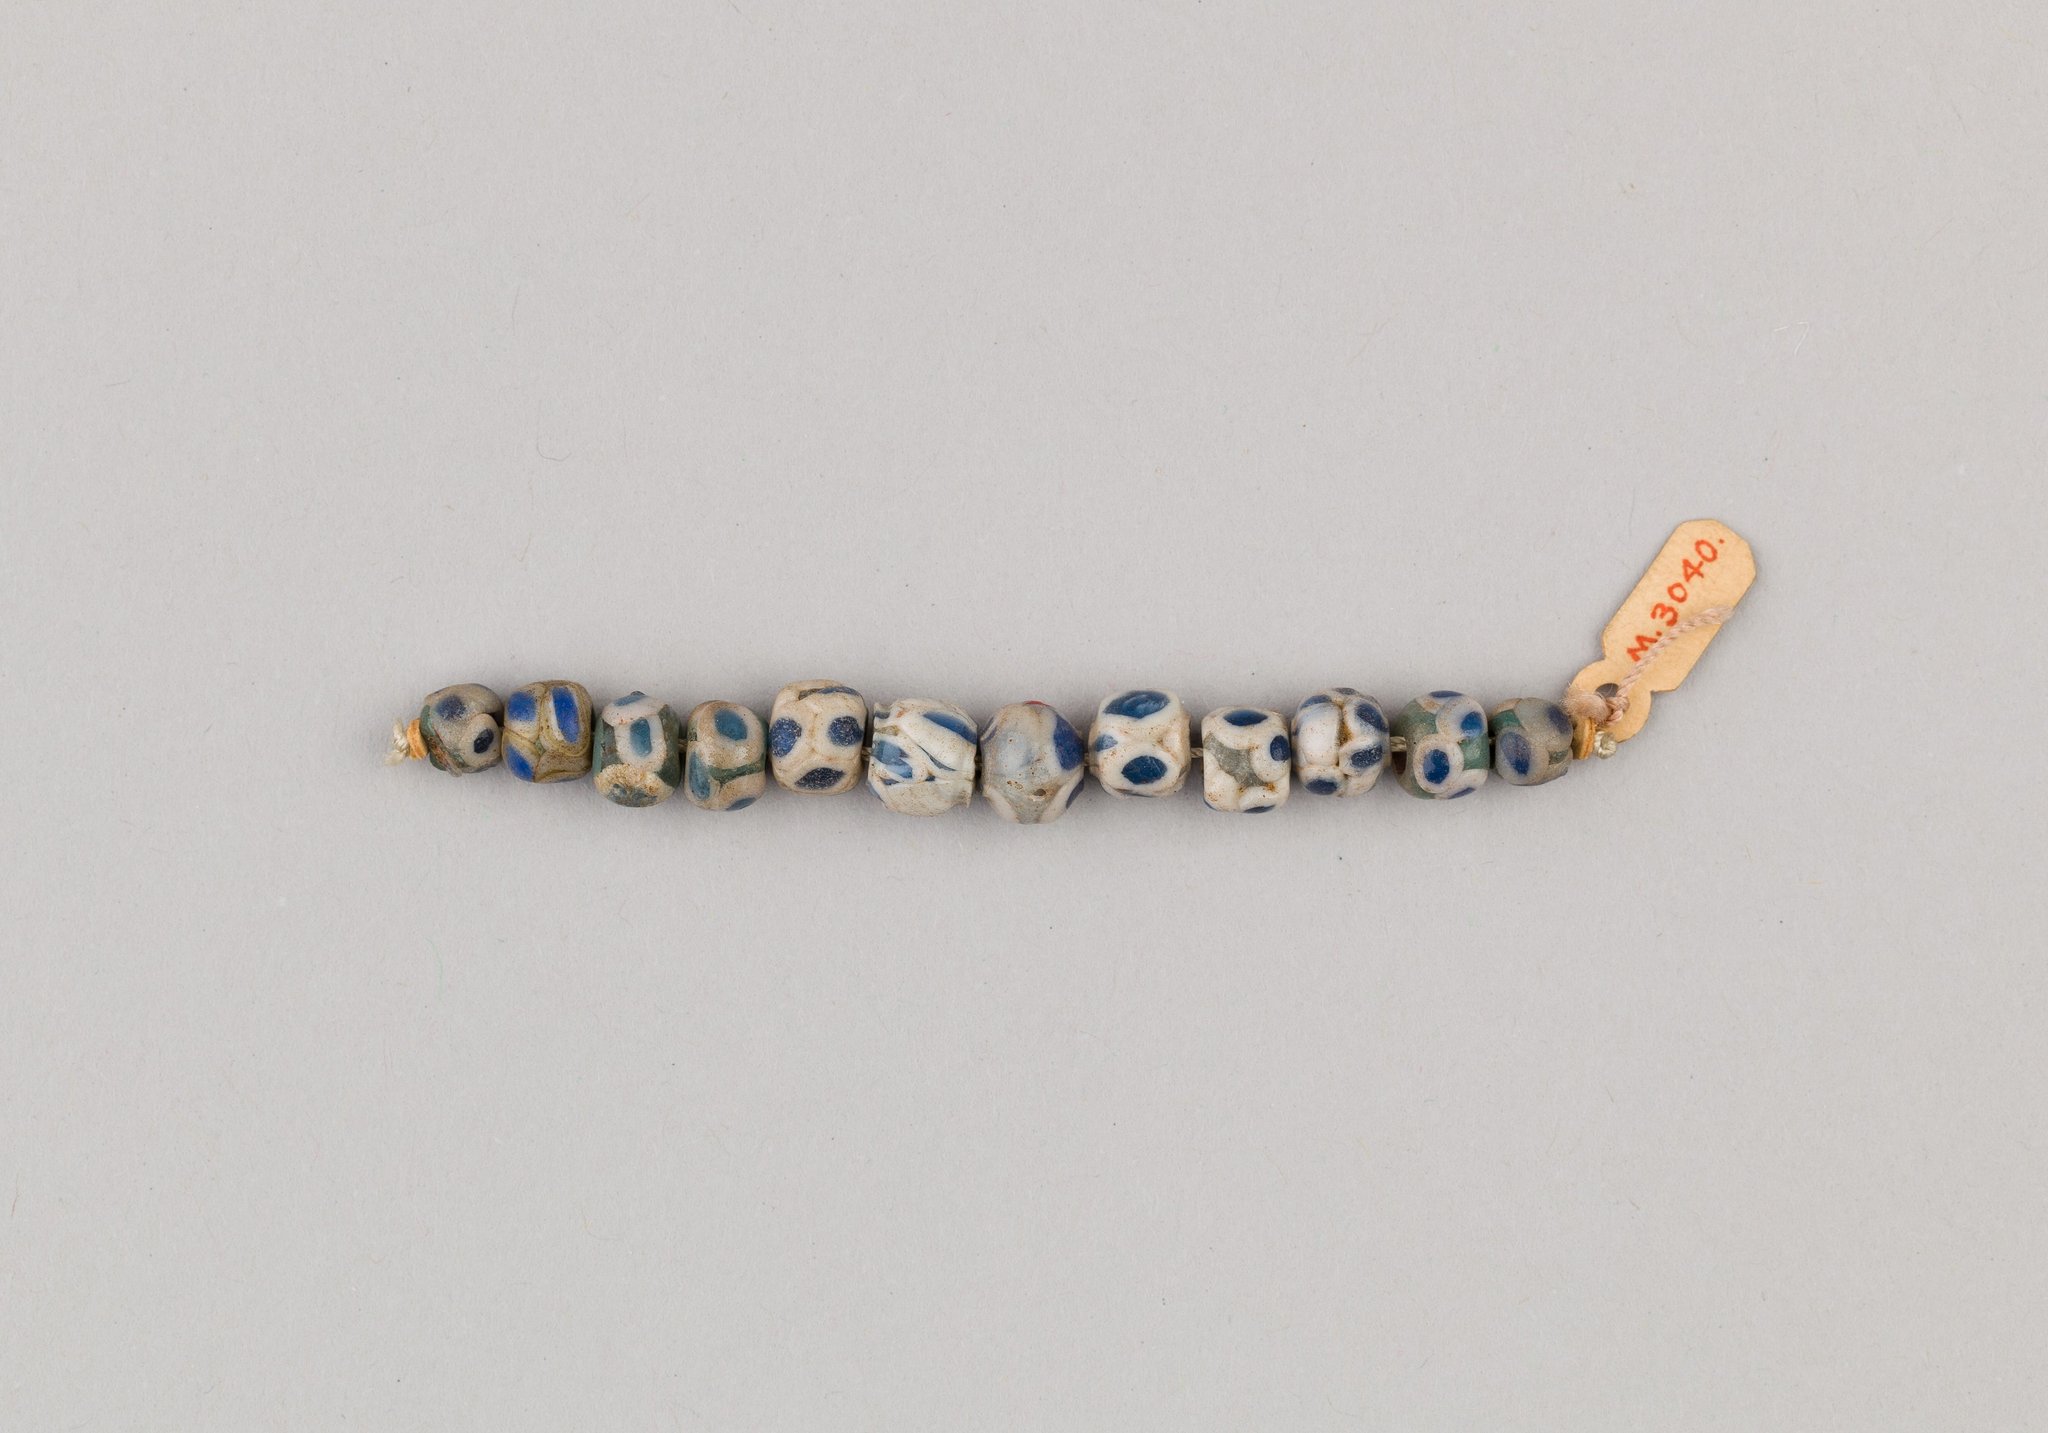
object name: bead, string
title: String of 12 Eyed Beads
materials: glass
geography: egypt